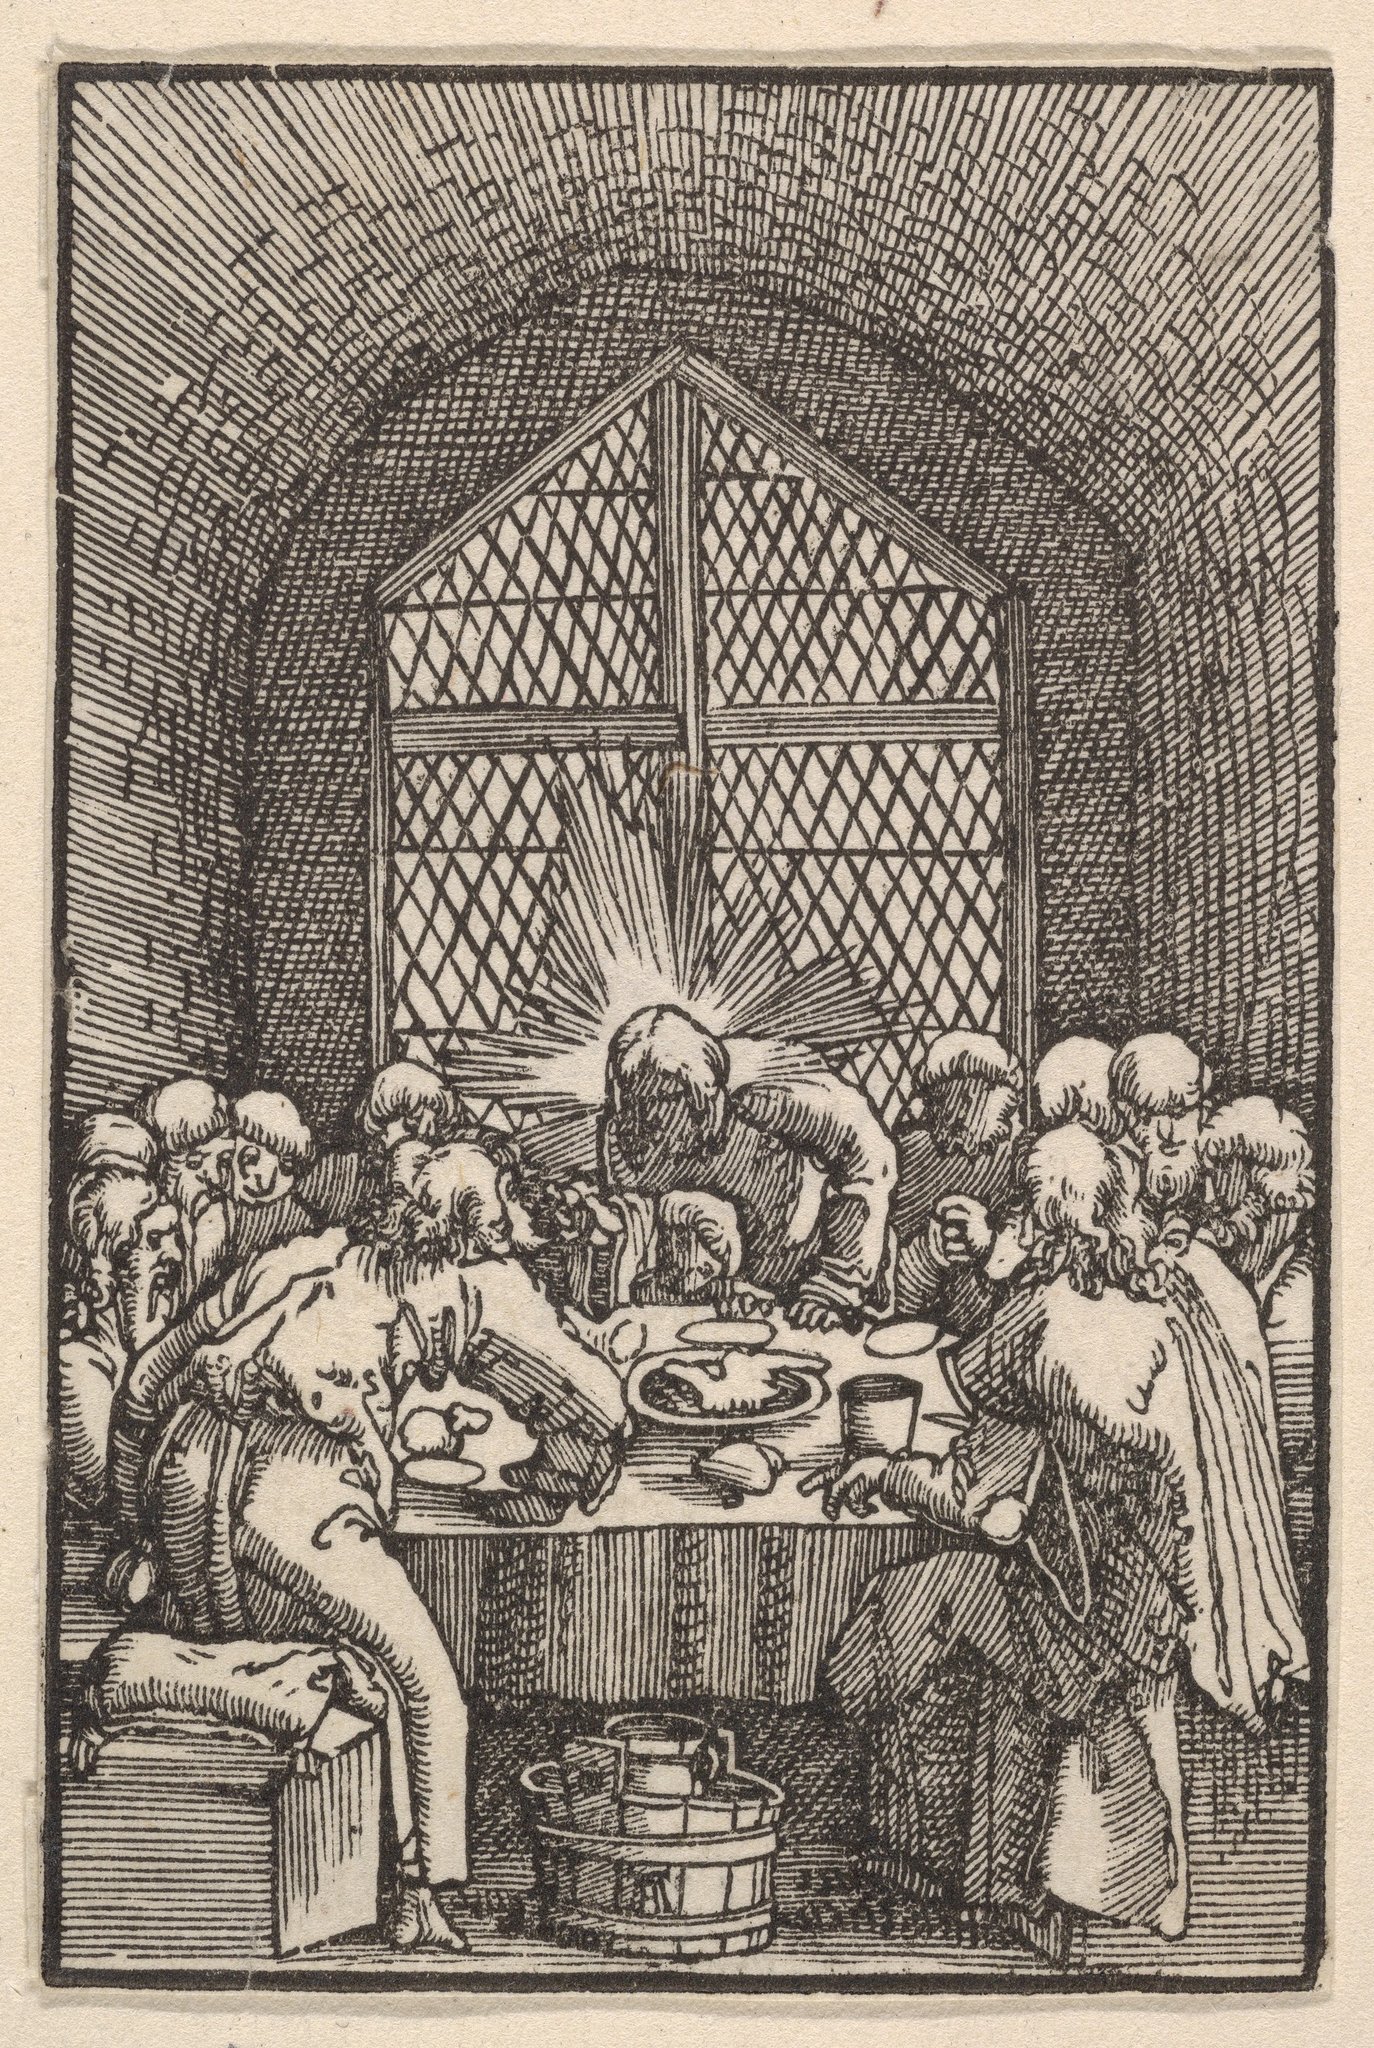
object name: print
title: The Last Supper, from "The Fall and Salvation of Mankind Through the Life and Passion of Christ"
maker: albrecht altdorfer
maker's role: artist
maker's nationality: german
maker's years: 1480-1538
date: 1513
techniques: woodcut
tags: apostles,christ,last supper